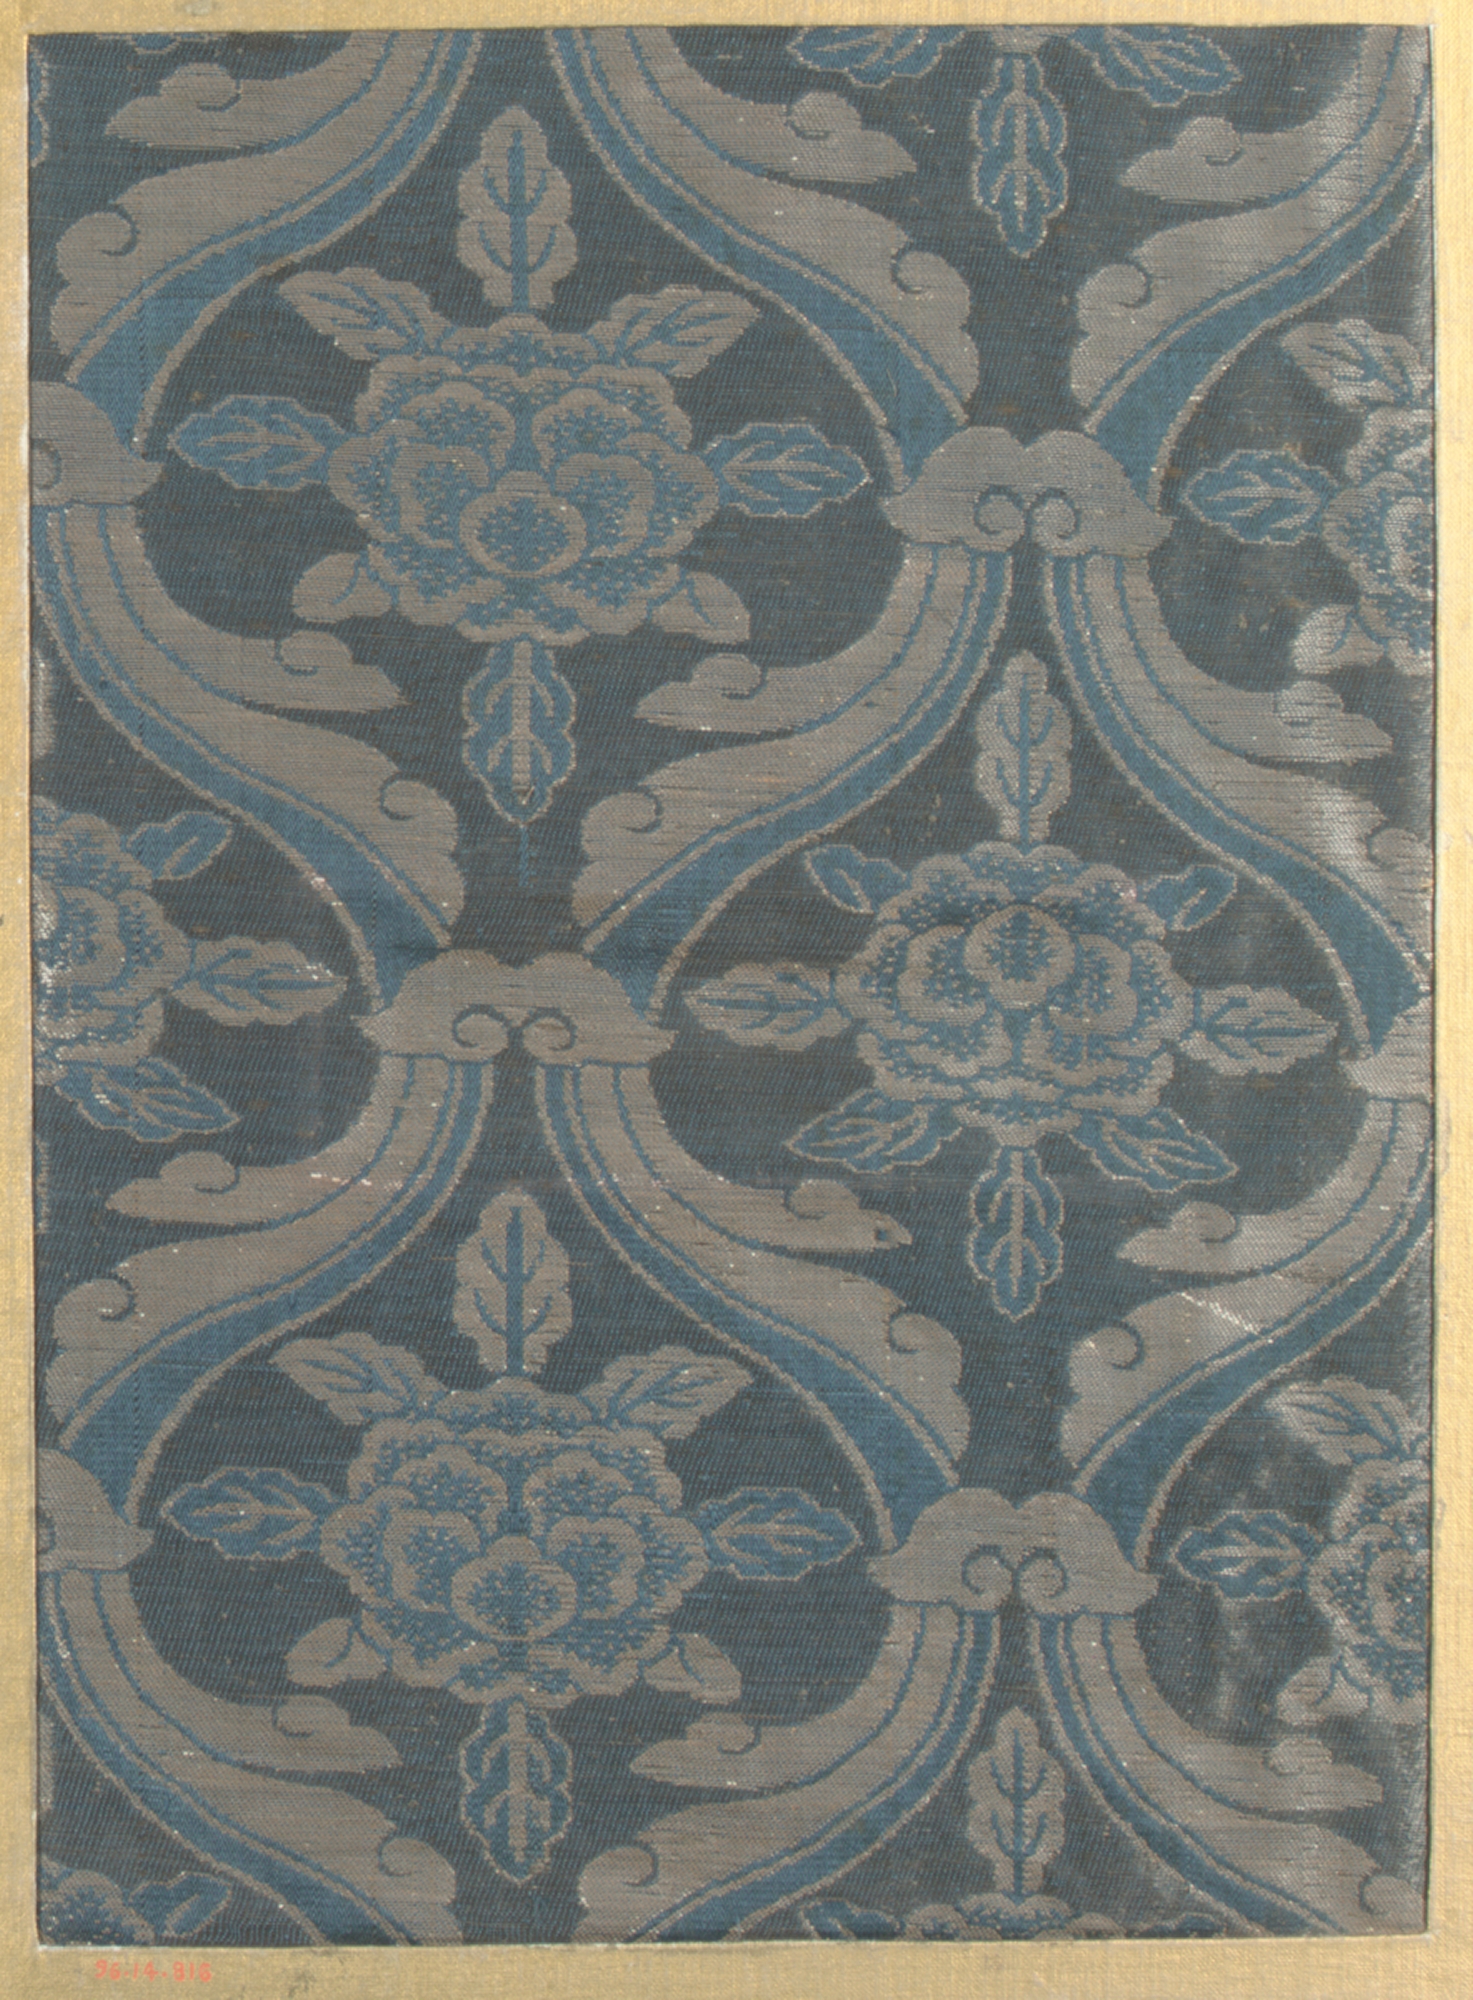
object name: piece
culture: japanese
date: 1701-1900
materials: silk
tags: flowers